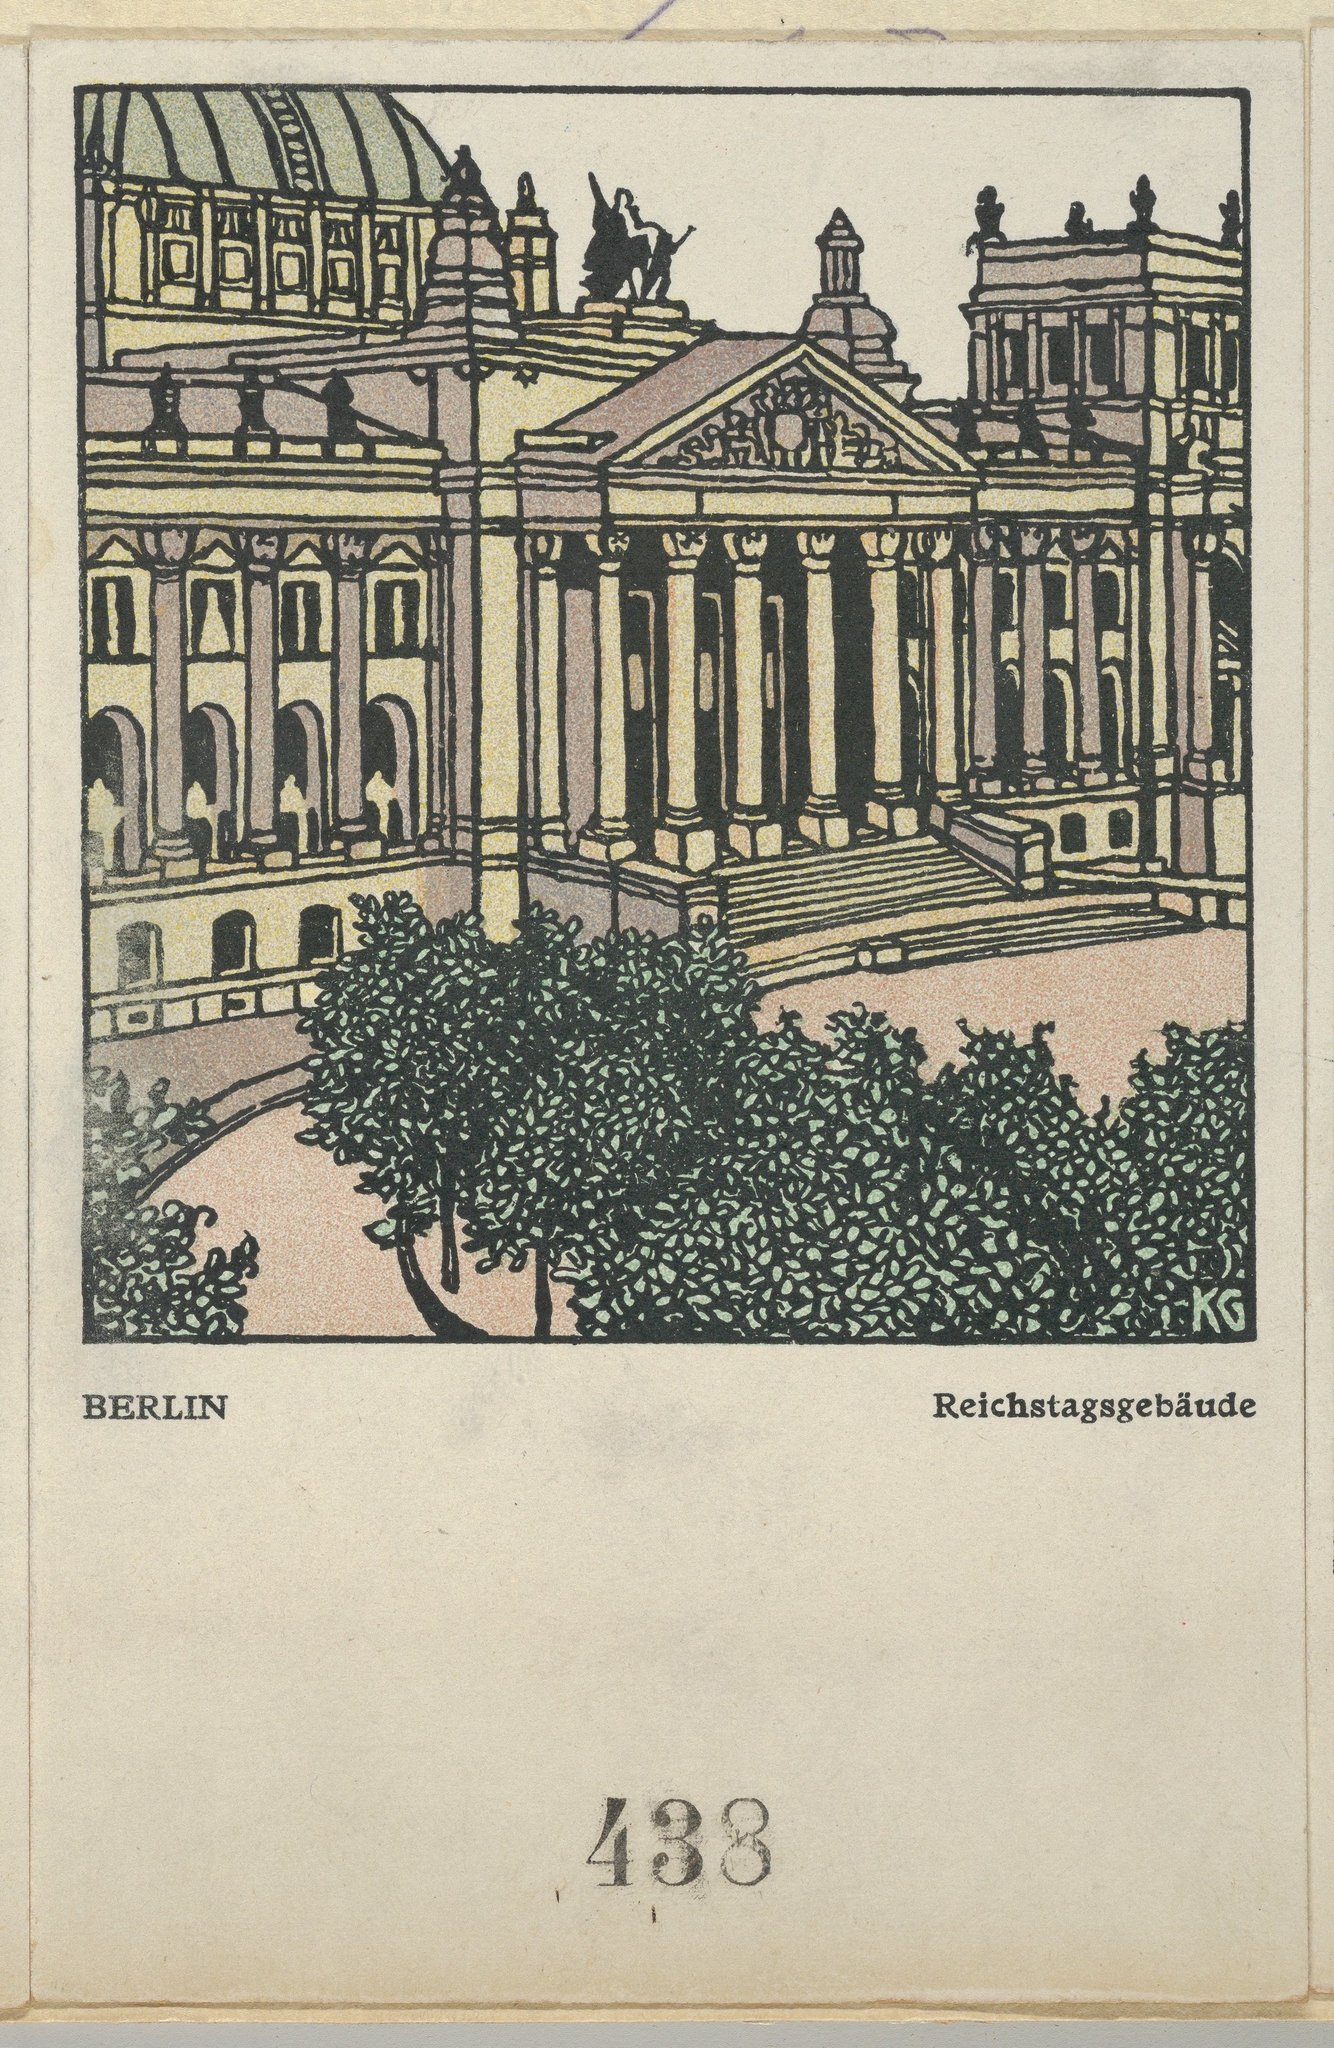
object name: print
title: Berlin: Reichstag Building (Reichstagsgebäude)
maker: gustav kalhammer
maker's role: artist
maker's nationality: austrian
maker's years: 1886-1919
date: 1911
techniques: lithograph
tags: buildings